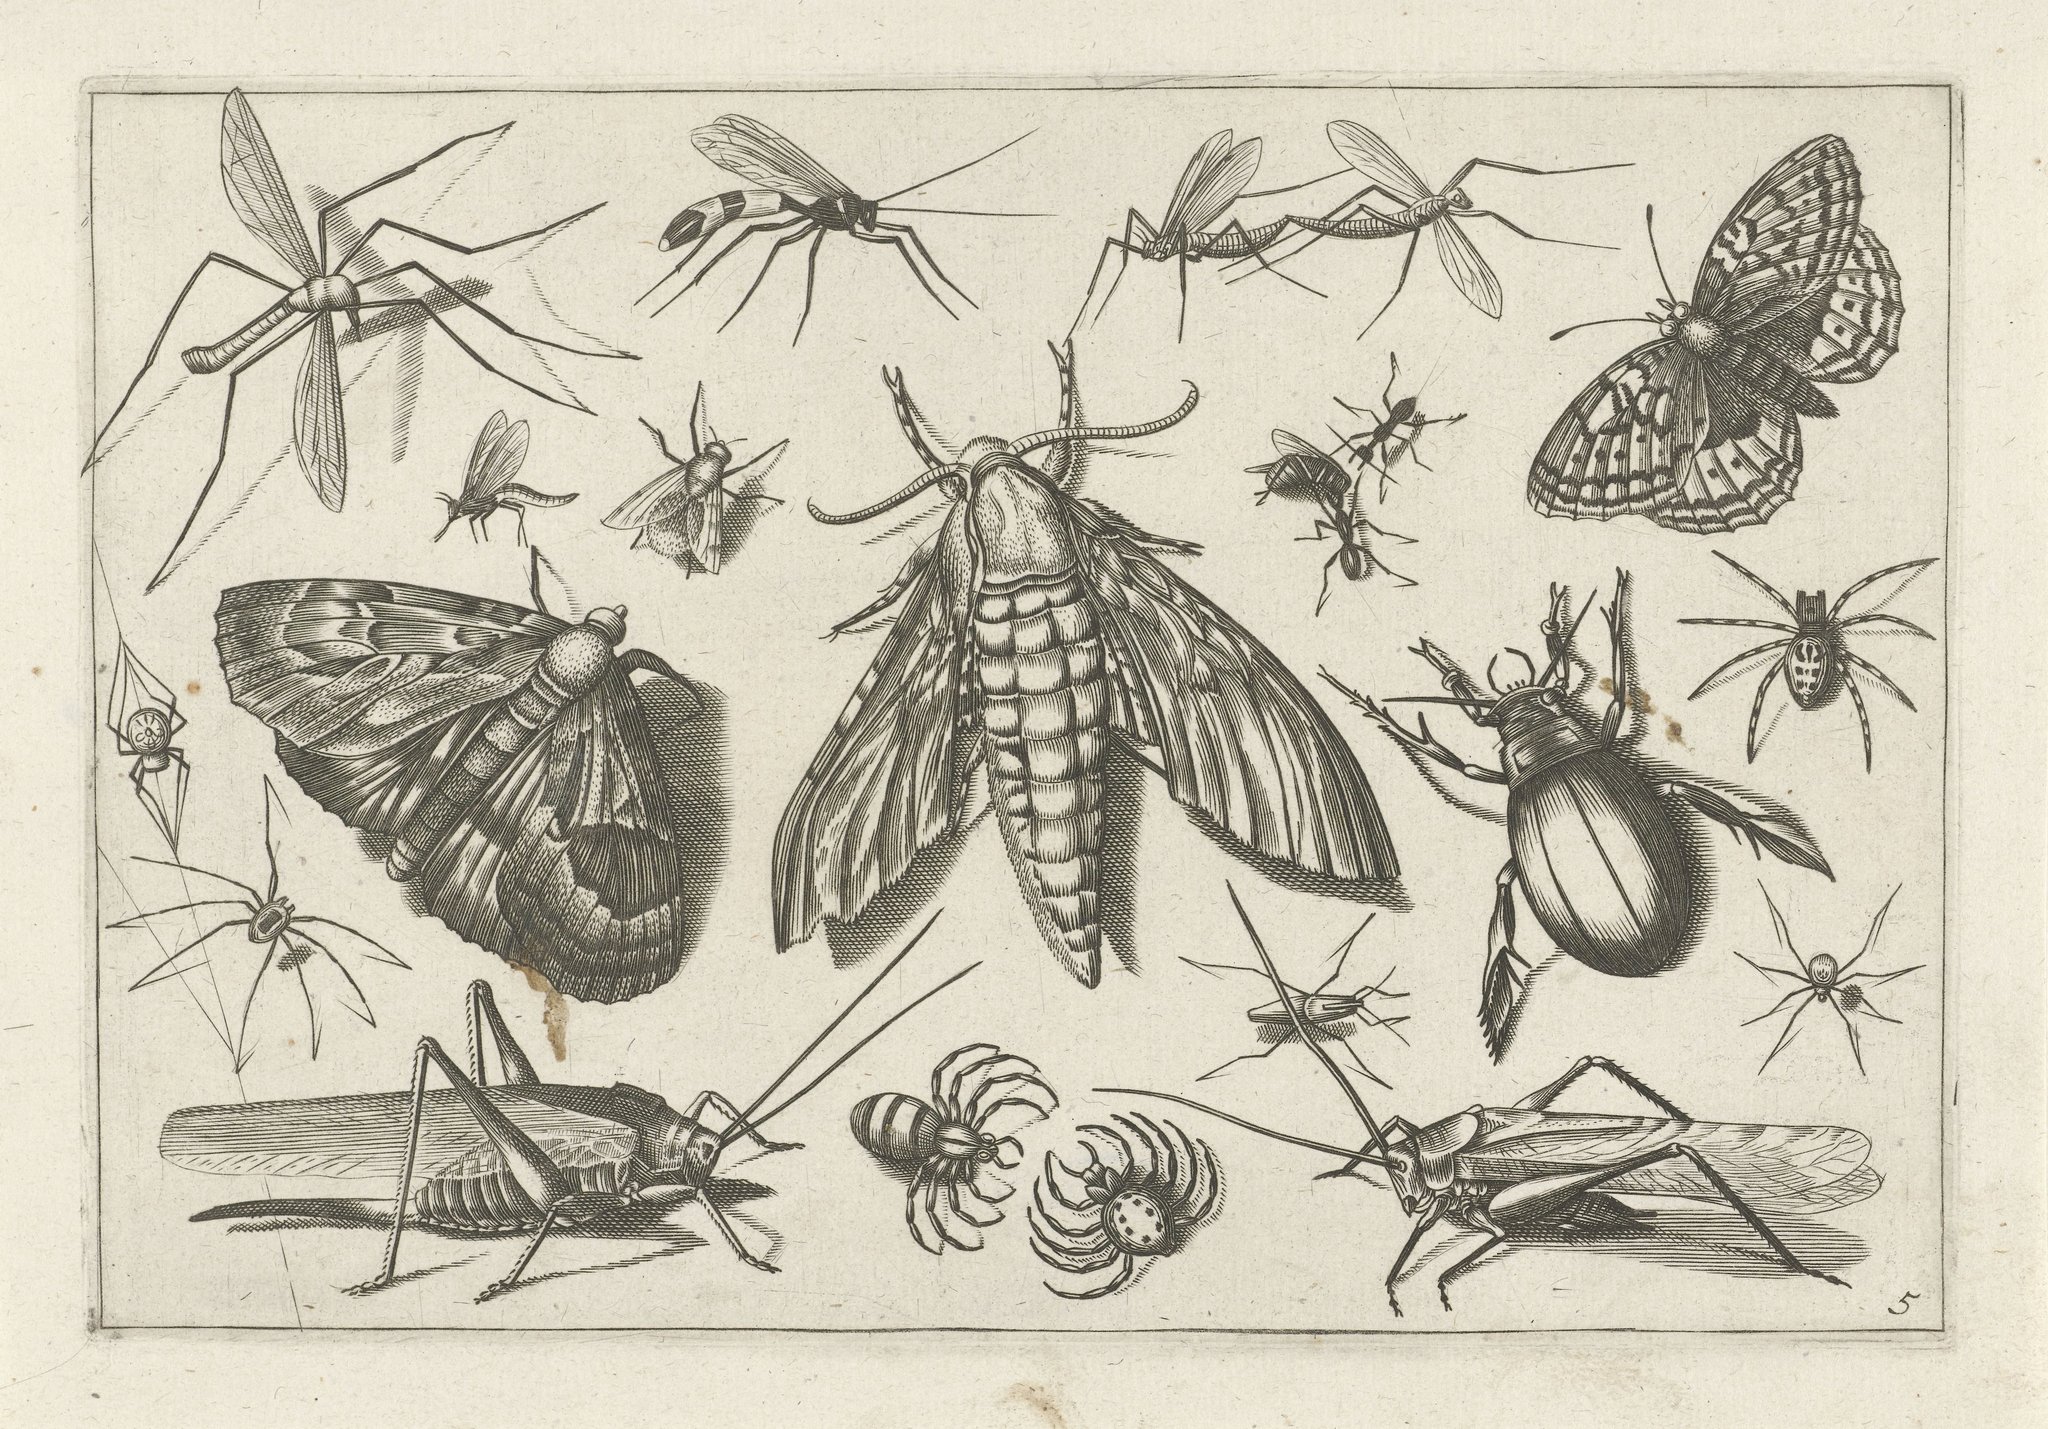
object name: print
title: Diversae Insectarum Volatilium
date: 1630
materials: paper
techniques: engraving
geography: low countries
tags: insects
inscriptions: collector's mark: Lugt 2228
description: Diverse insecten met in het midden een mot.